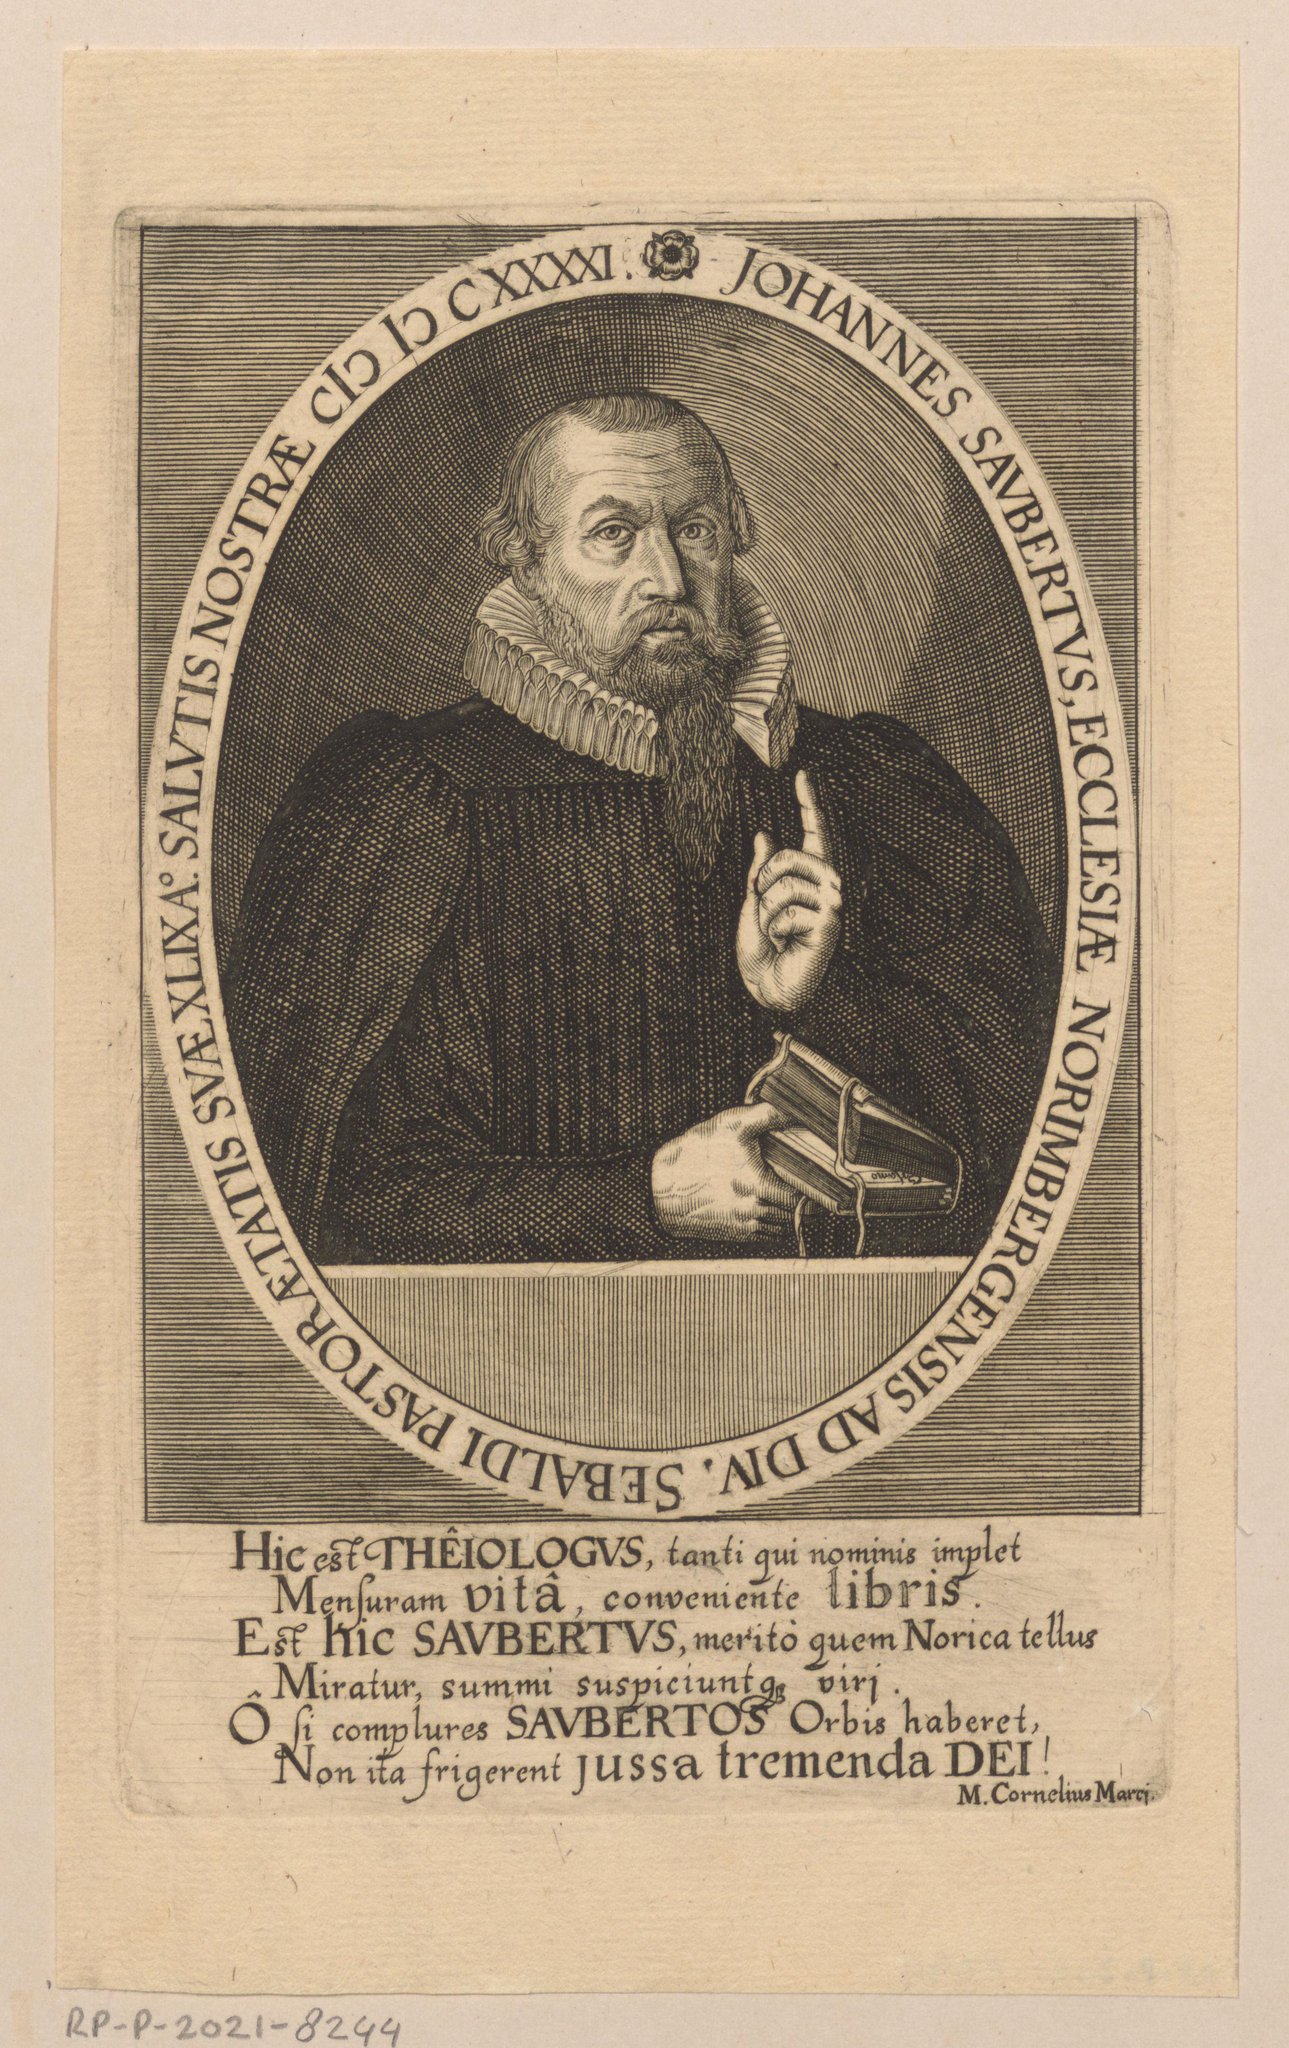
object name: print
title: Portret van Johann Saubert I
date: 1641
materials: paper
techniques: engraving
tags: johann saubert (i), theologian, historical persons, book